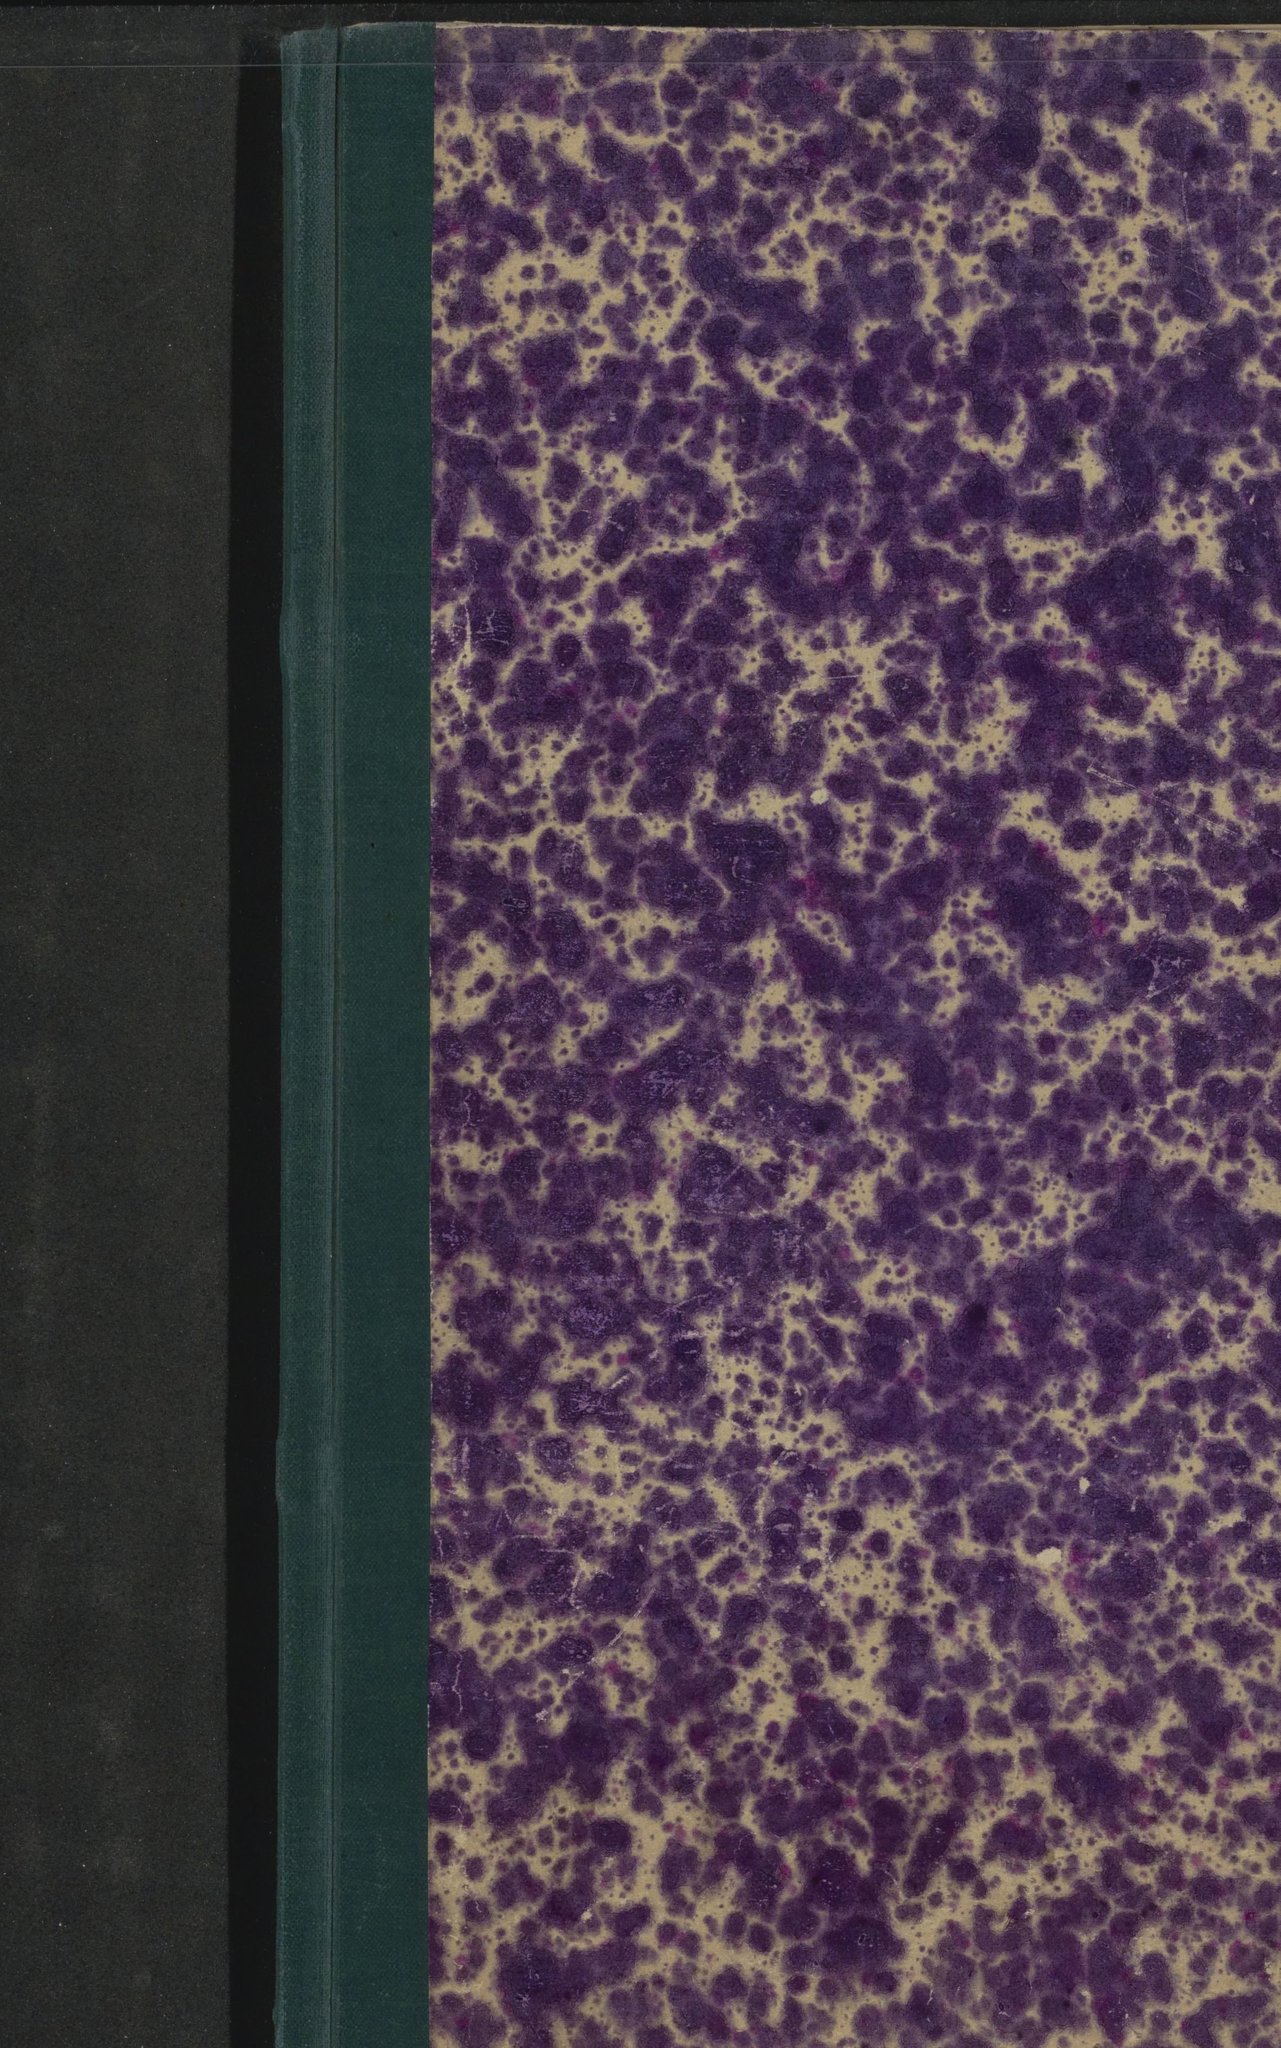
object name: verzamelalbum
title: Album met 32 bladen met tekeningen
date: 1843-1864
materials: cardboard, ink, linen, paper, pencil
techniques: brush, pen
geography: amsterdam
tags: animals, historical persons (portraits and scenes from the life)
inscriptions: collector's mark: Lugt 2166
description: Verzamelalbum bestaande uit 32 bladen met (deels ingeplakte) tekeningen gemaakt door leden van de vierde klasse van het Koninklijk Instituut van Wetenschappen, Letterkunde en Schoone Kunsten en leden van de Maatschappij Arti et Amicitiae te Amsterdam. Onder andere portretten, figuren en dieren.